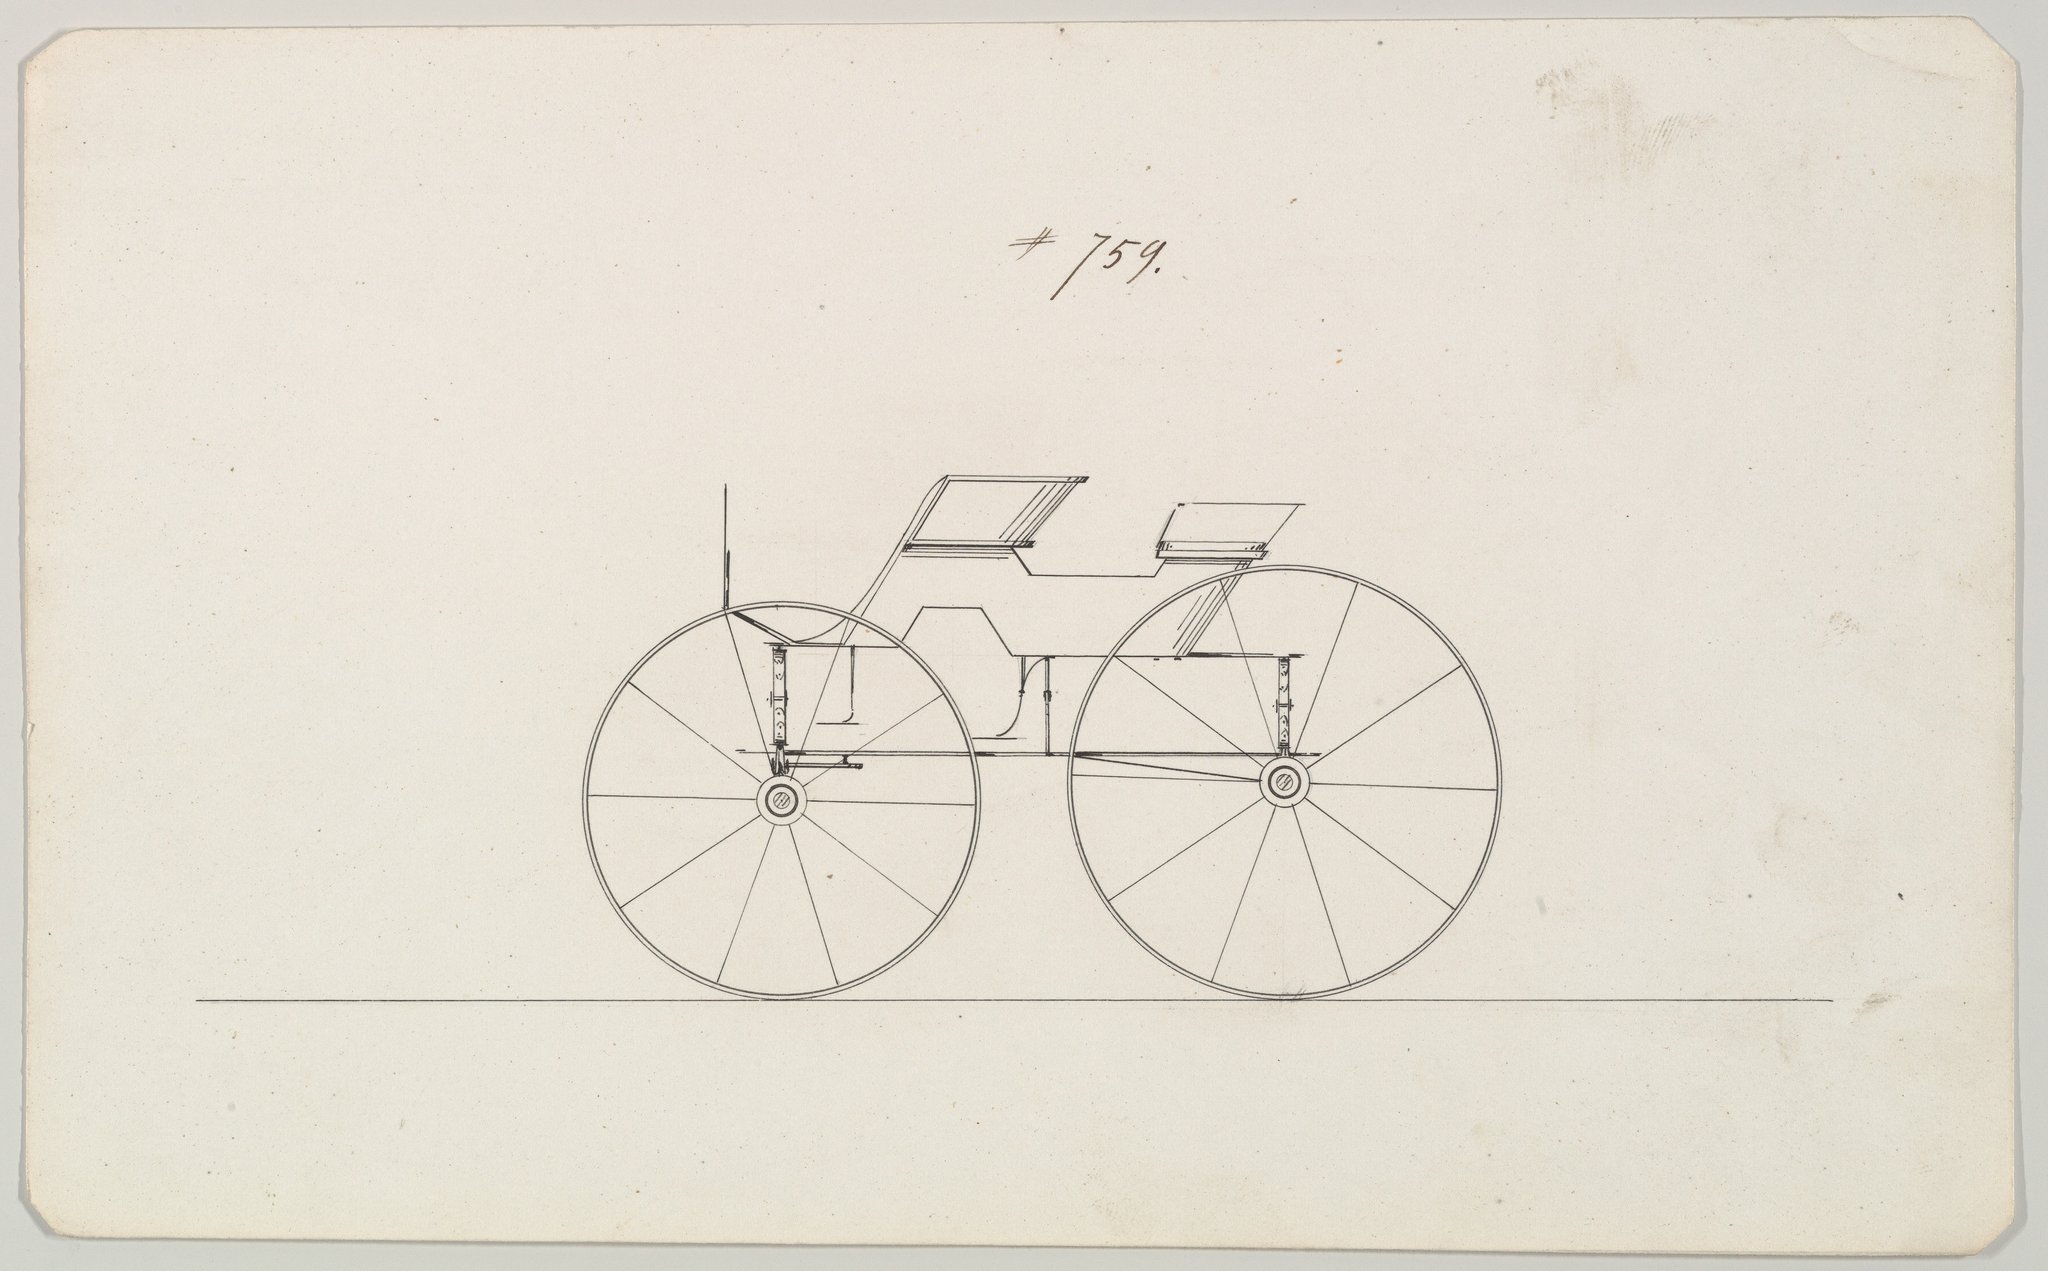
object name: drawing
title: Design for Wagon, no. 759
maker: brewster & co.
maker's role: manufacturer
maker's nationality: american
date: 1860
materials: ink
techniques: pen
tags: carriages